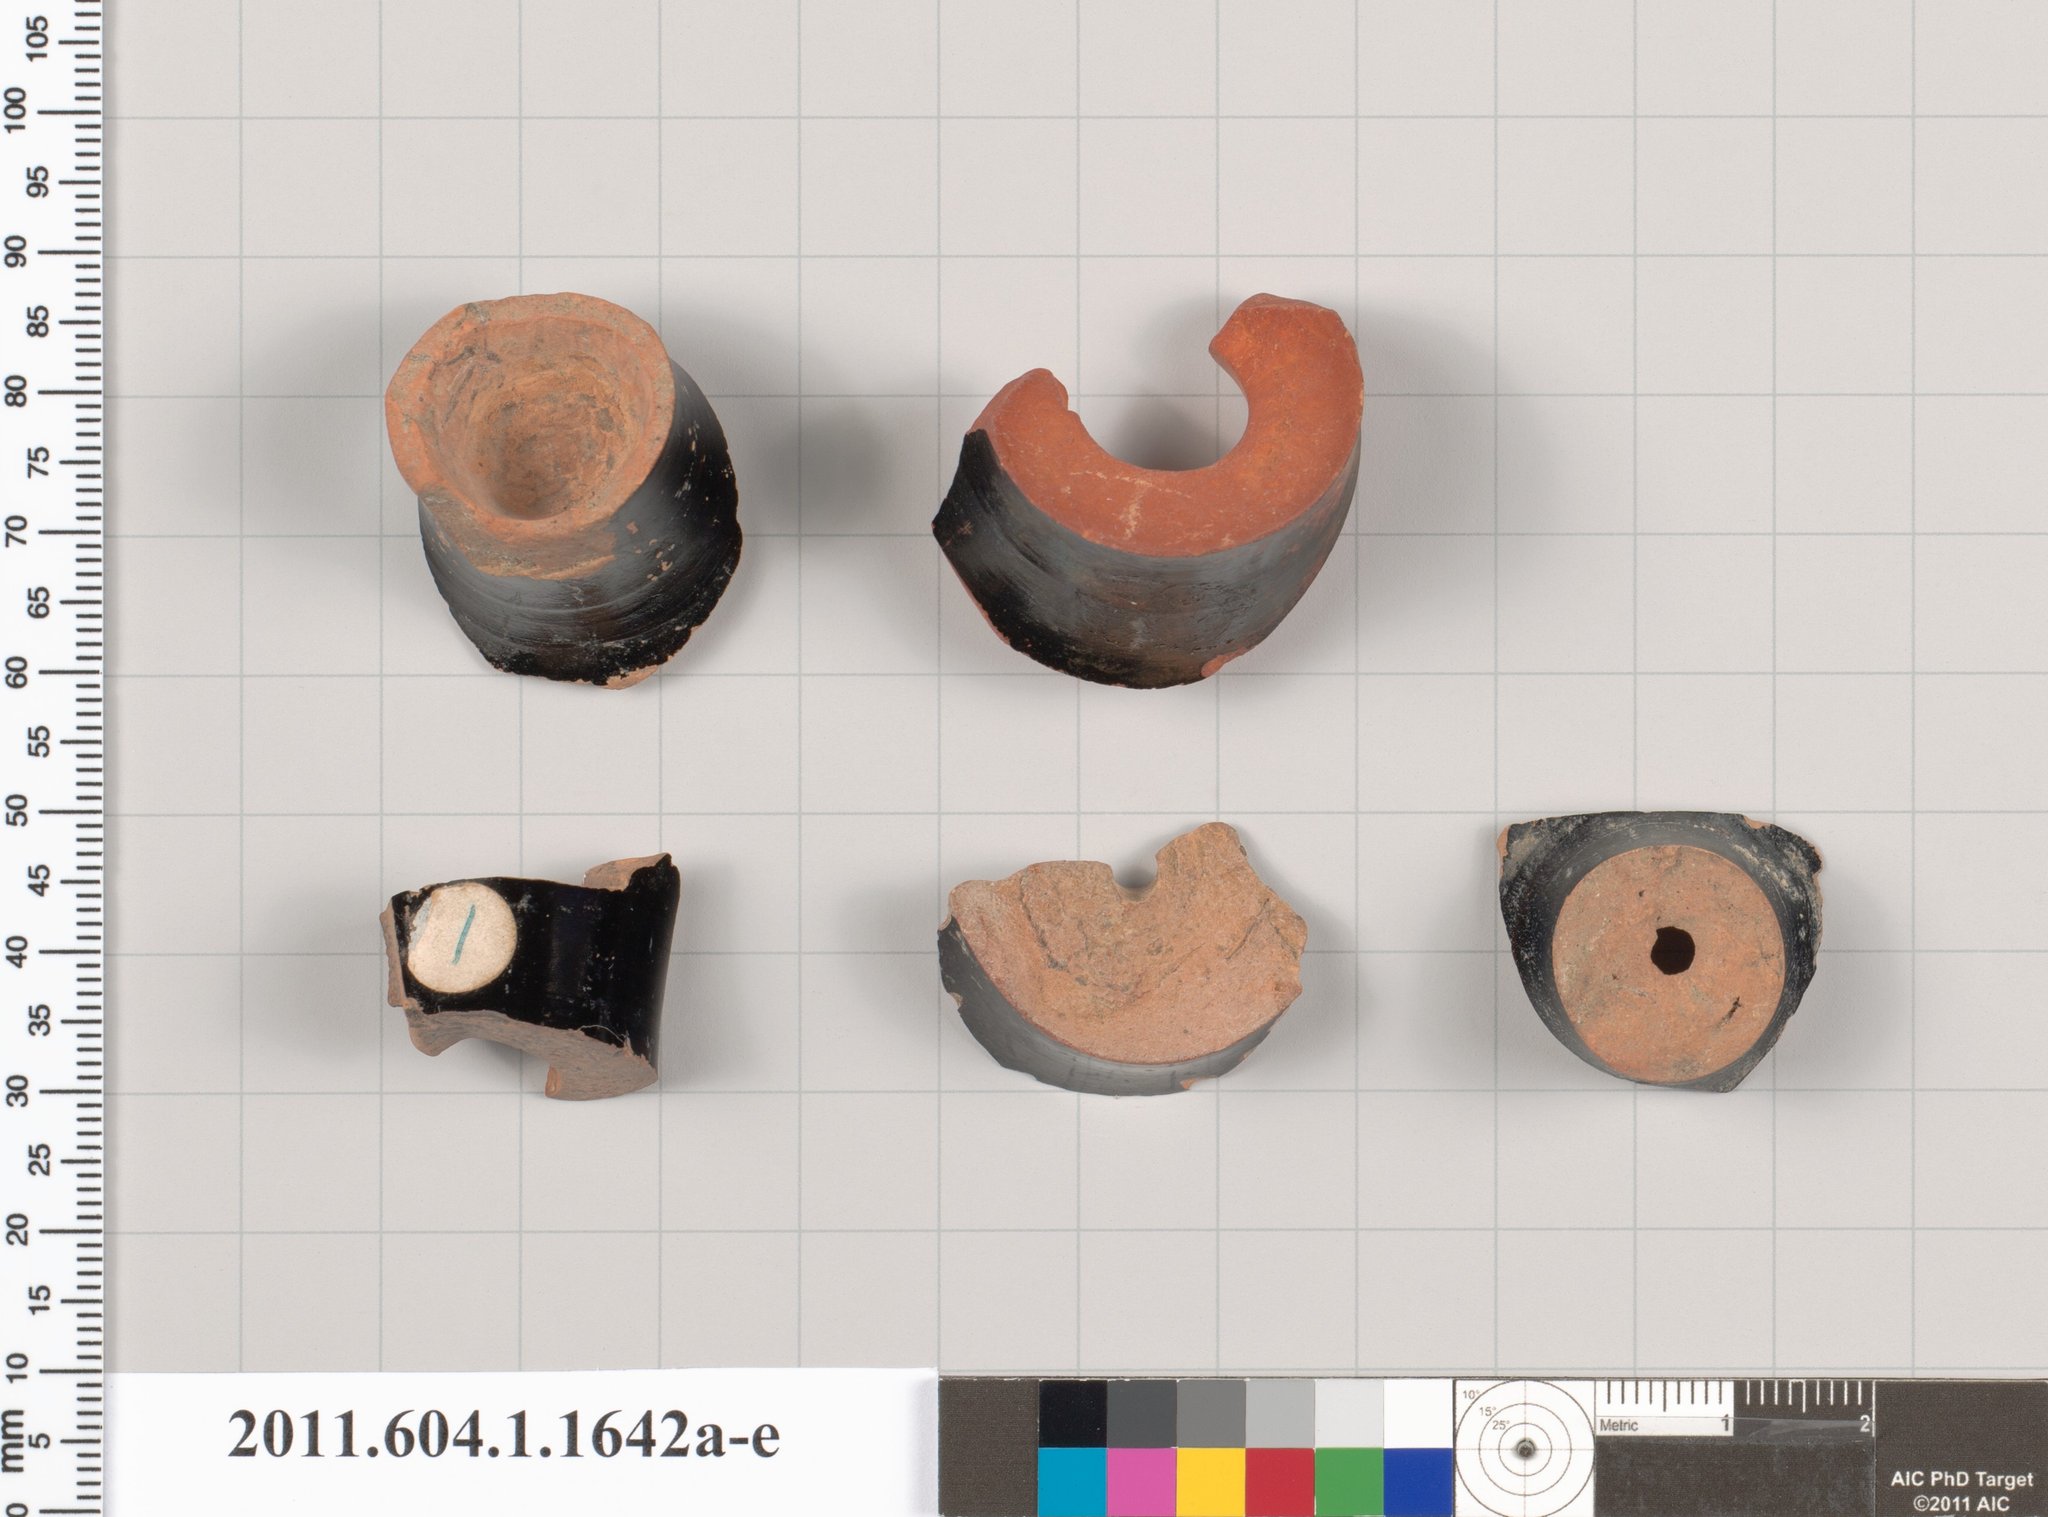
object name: kylix fragment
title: Terracotta fragments of kylikes (drinking cups)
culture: greek, attic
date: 500-401 BCE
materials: terracotta